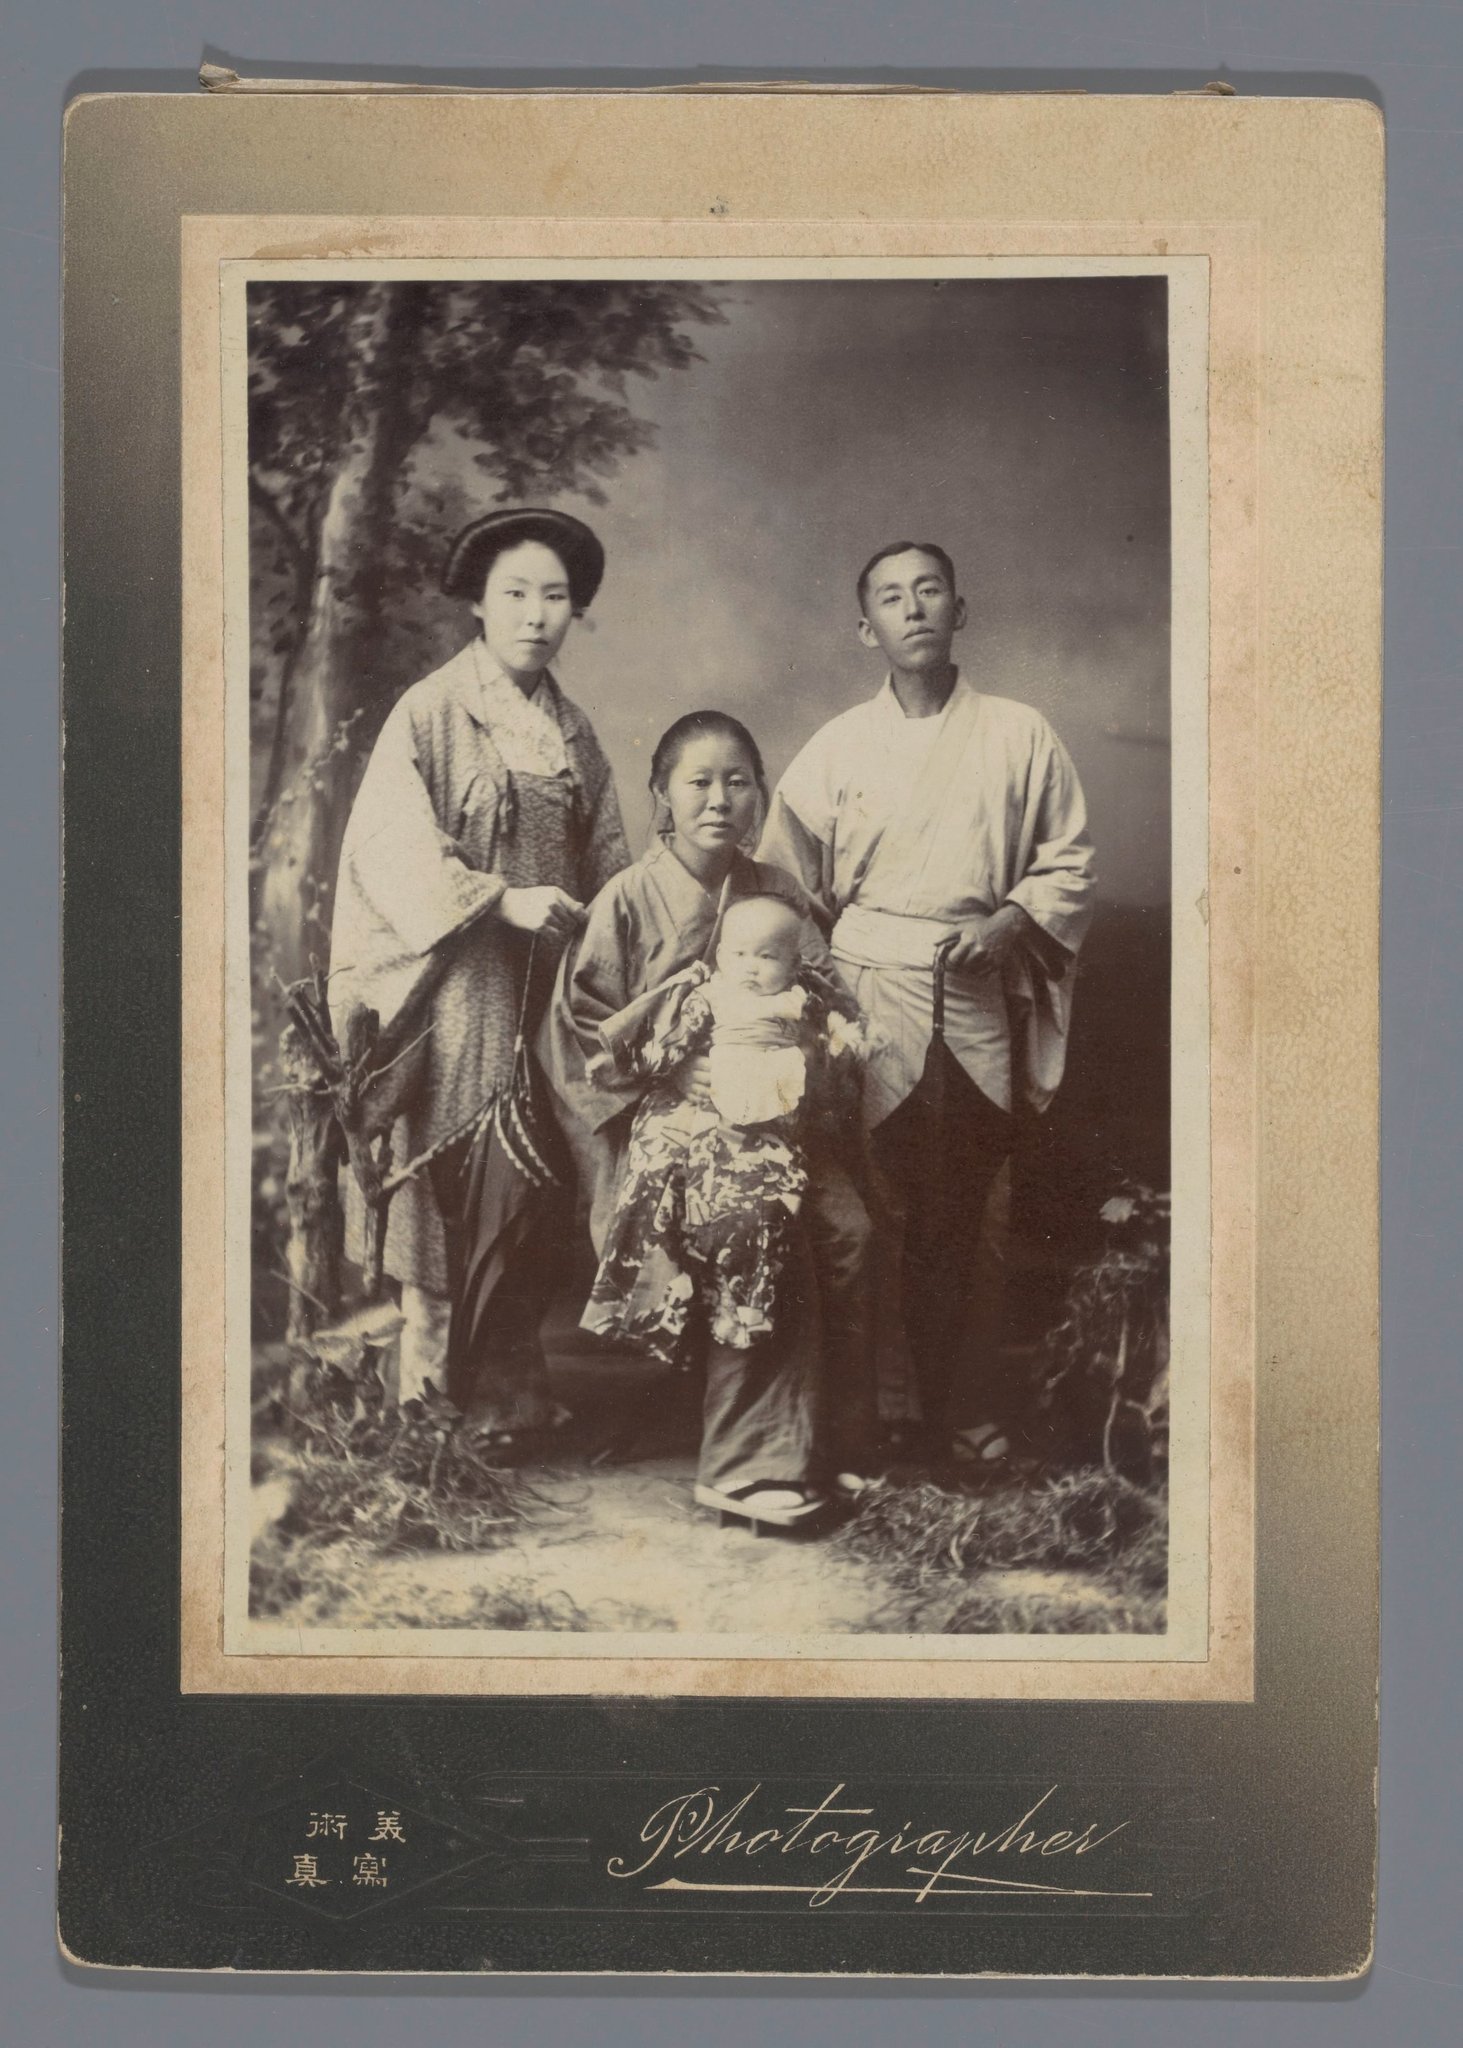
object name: photograph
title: Groepsportret van een onbekend Japans gezin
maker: Anonymous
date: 1890-1920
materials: paper, cardboard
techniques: collodion silver print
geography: japan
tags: family, descendance, anonymous historical persons portrayed in a group, in a group-portrait, japan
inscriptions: inscription: ‘Photographer’